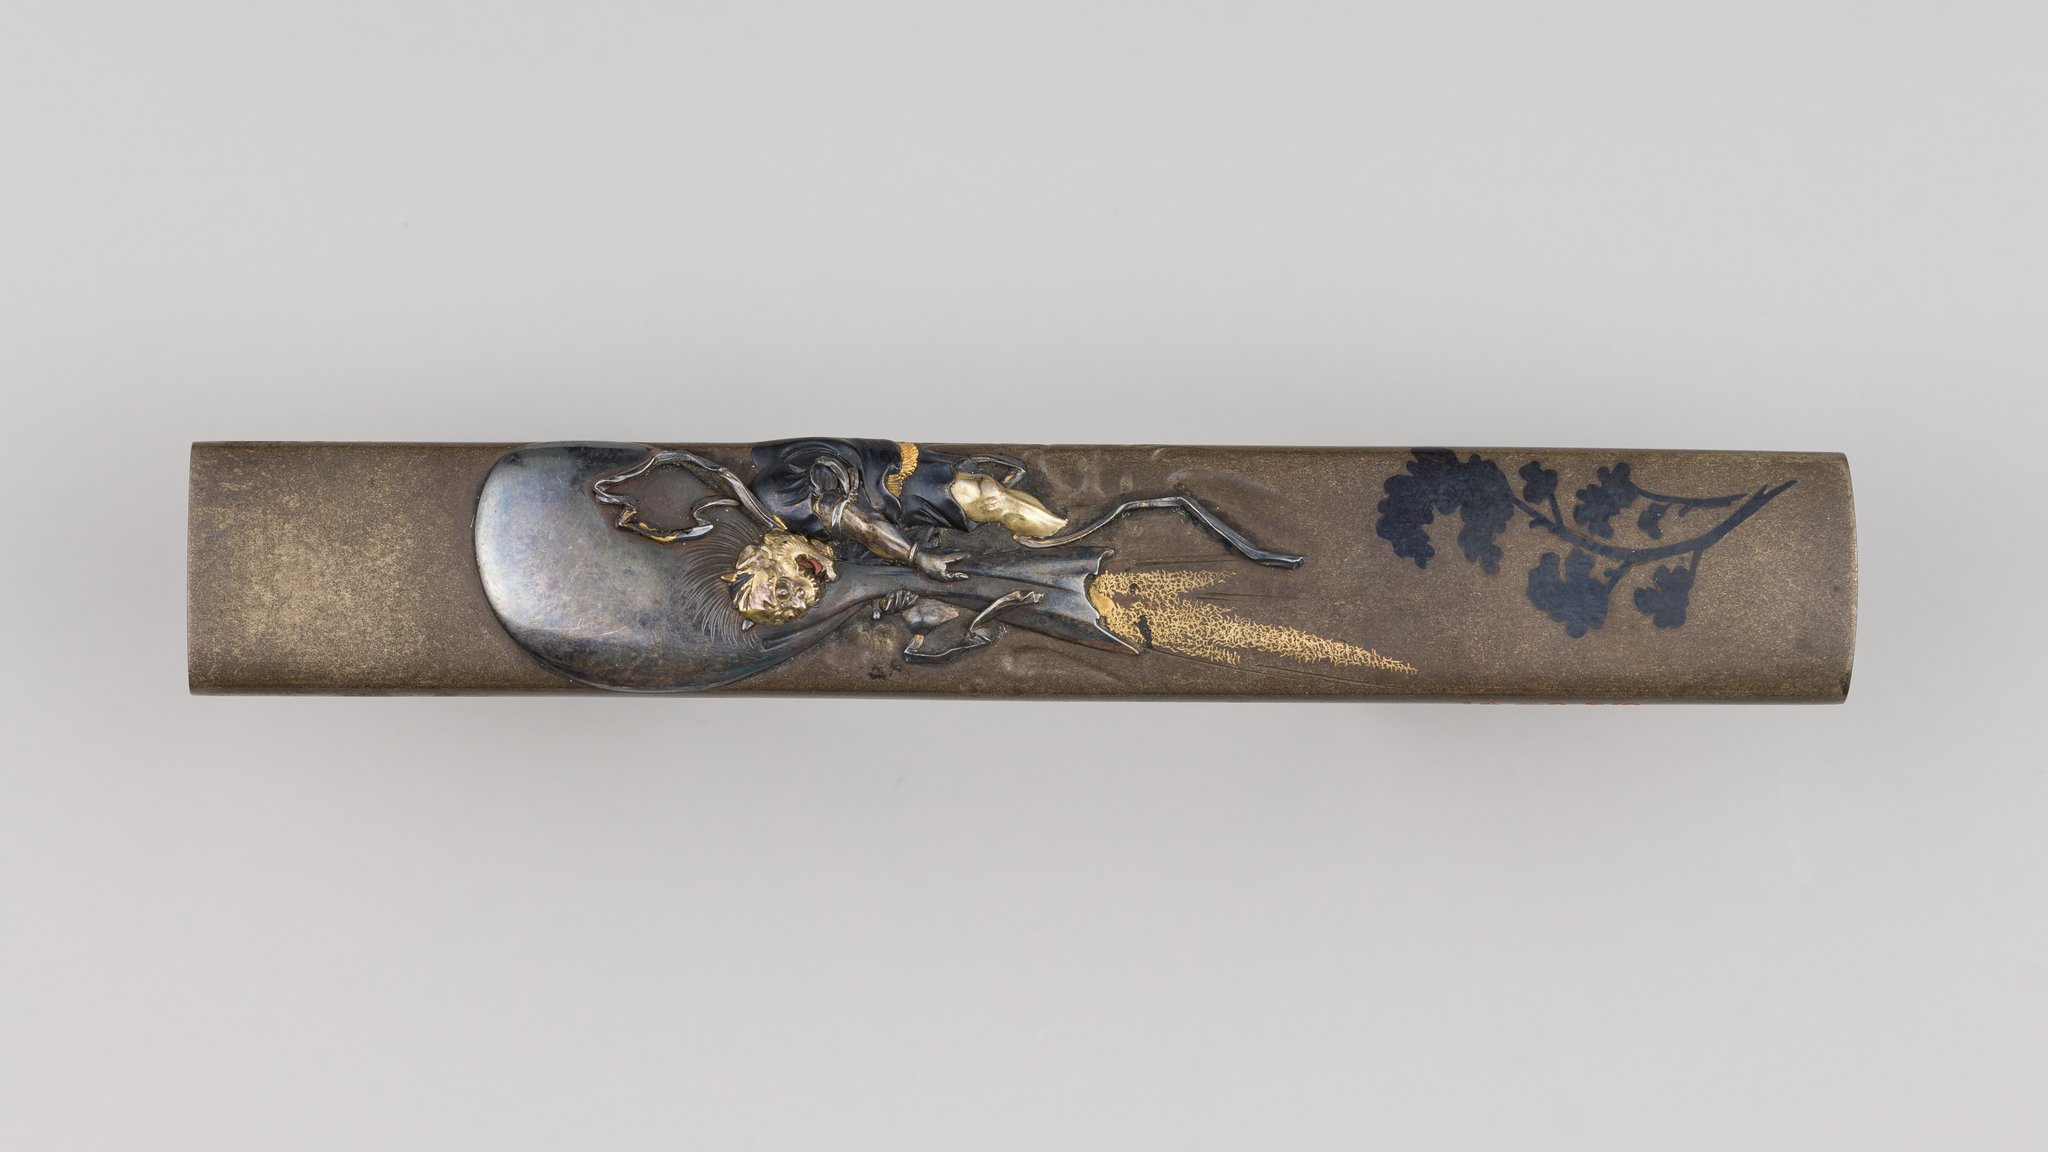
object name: knife handle kozuka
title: Knife Handle (Kozuka)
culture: japanese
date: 1701-1800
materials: copper, gold alloy, silver alloy, gold, silver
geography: japan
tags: men,demons